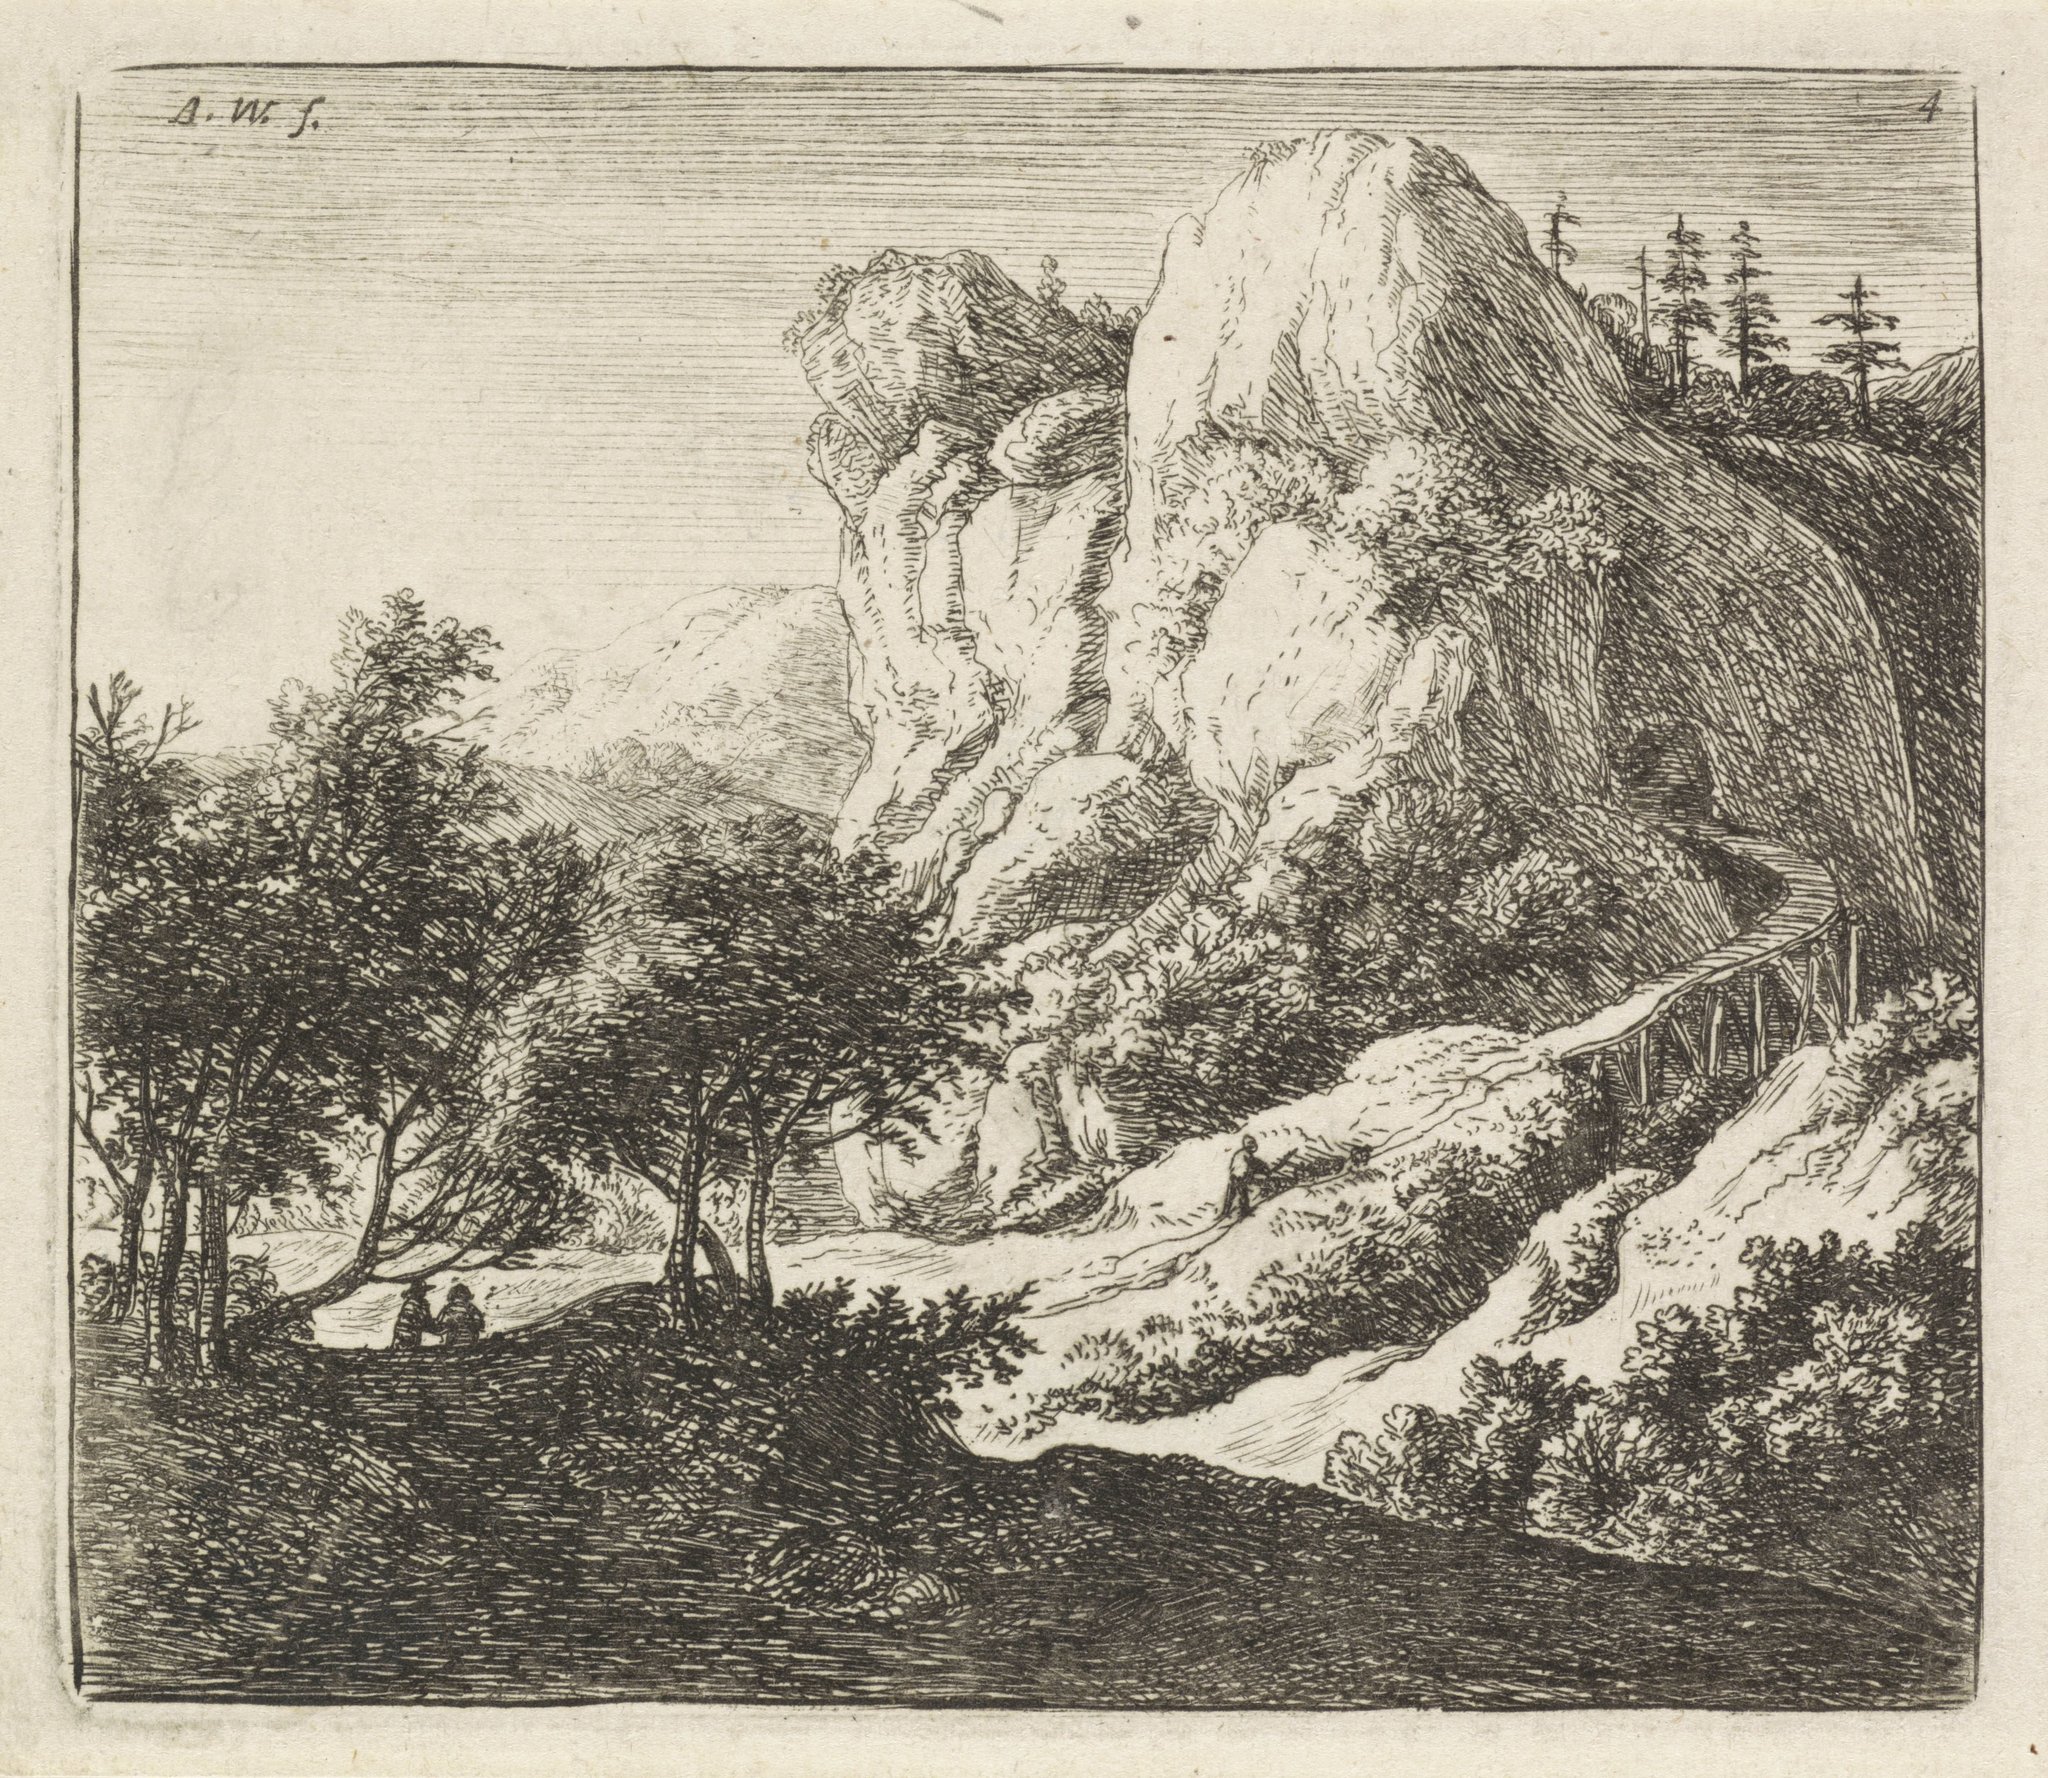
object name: print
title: Houten brug bij een rotspartij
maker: anthonie waterloo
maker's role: draughtsman, painter, print maker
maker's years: 1609-1690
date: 1630-1663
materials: paper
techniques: etching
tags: herding, herdsman, herdswoman, shepherd, shepherdess, cowherd, etc., bridge, rocks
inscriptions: collector's mark: Lugt 2228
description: Rechts loopt een herder met zijn kudde in de richting van een houten brug die gedeeltelijk door een rotspartij voert. Linksvoor twee figuren onder bomen.